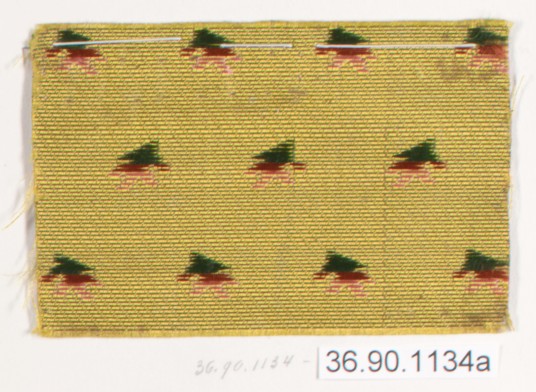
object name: sample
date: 1701-1900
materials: metal thread, silk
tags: flowers